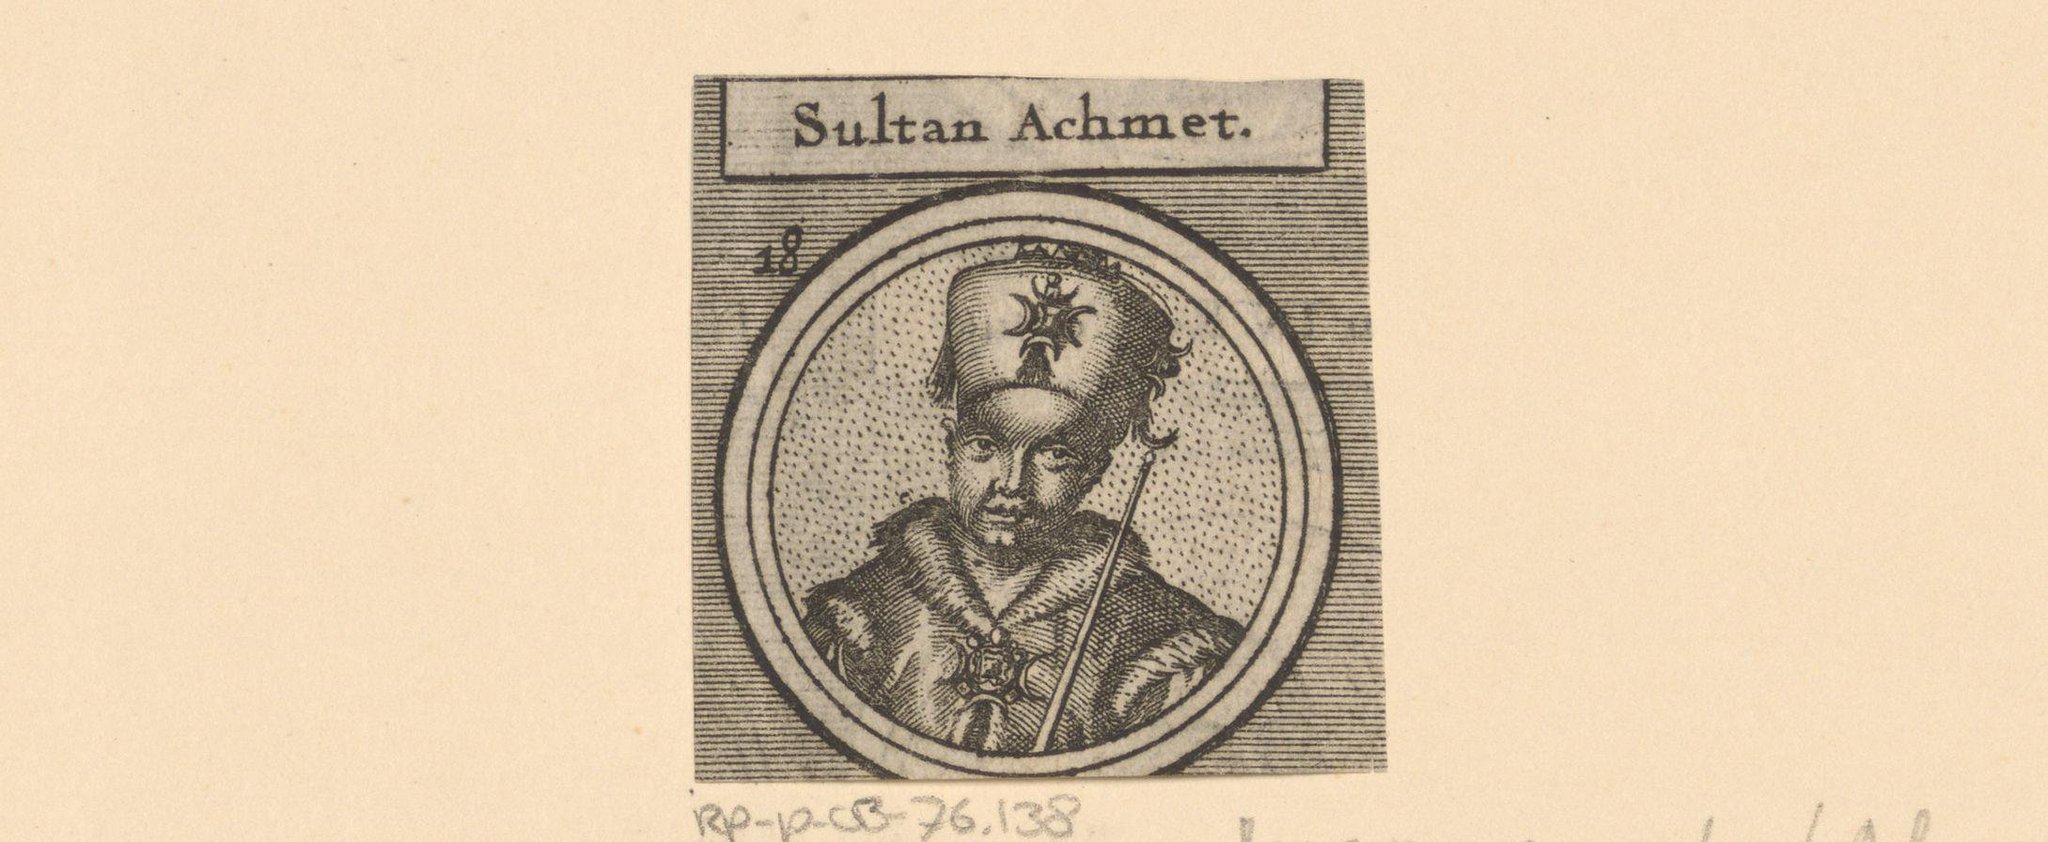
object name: book illustration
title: Portret van Ahmed I, II of IV, sultan van het Ottomaanse Rijk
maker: Anonymous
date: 1600-1799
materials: paper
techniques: engraving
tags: sceptre, staff (symbol of sovereignty), head-gear: turban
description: Portret van Ahmed I, II of IV in een cirkelvormige omlijsting. Hij draagt een tulband en een scepter. In een kader zijn naam en titel. Linksboven: 18.